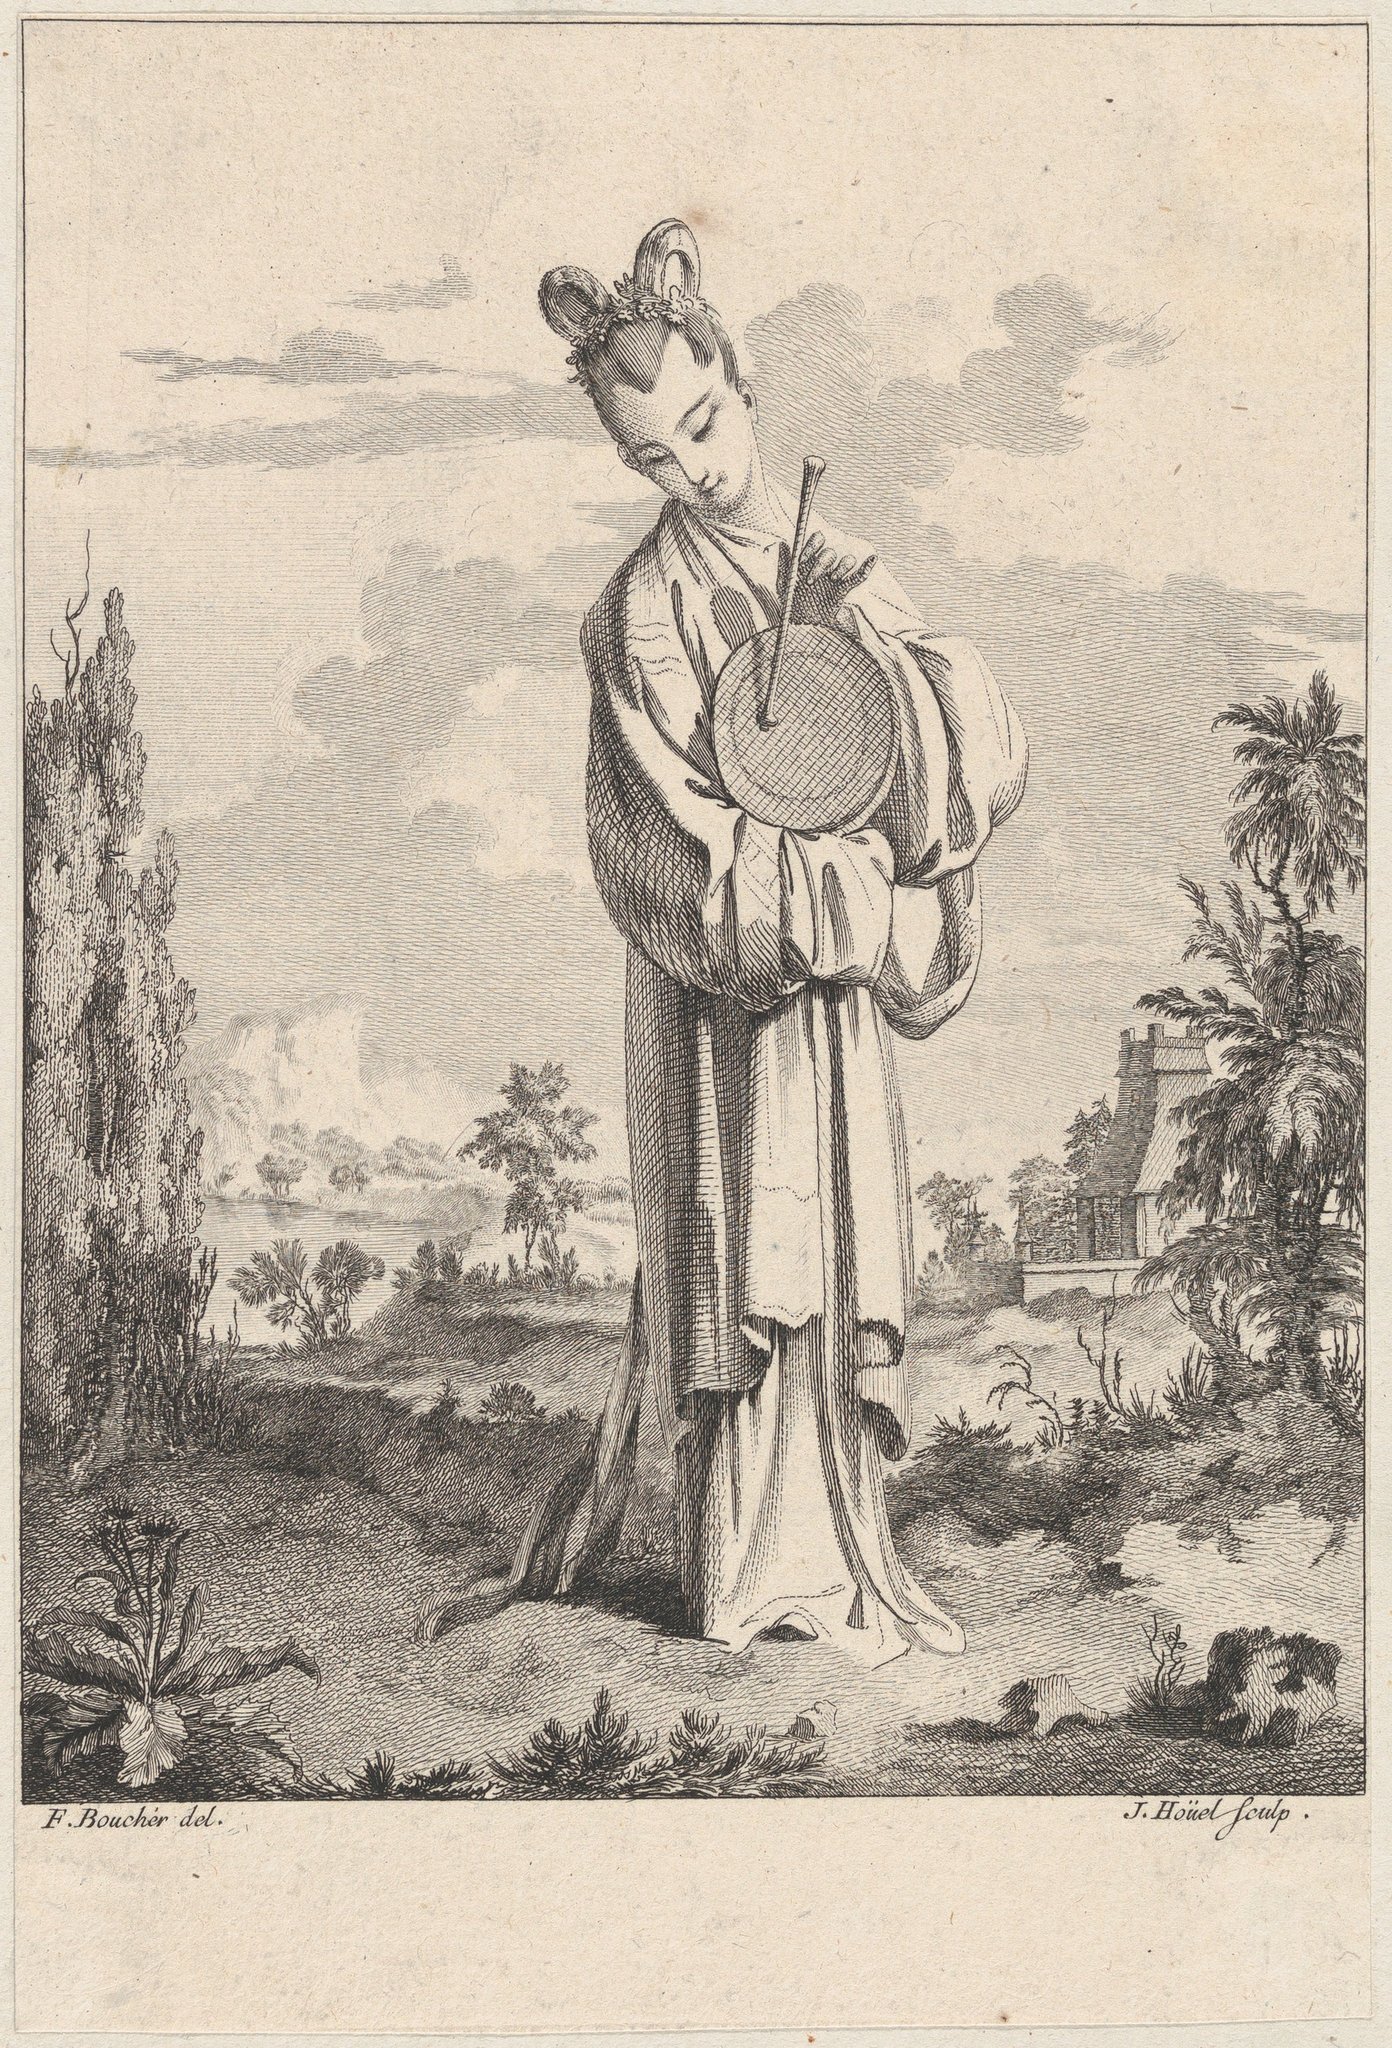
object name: print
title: Chinoiserie with a woman playing a gong, from Suite de Figures Chinoises. . .Tiré du Cabinet de Mr. d'Azaincourt (Series of Chinoiserie Figures. . .From the Chambers of Mr. d'Azaincourt)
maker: jean pierre louis laurent hoüel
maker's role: artist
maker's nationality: french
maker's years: 1735-1813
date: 1755-1776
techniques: engraving, etching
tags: musical instruments,chinoiserie,women